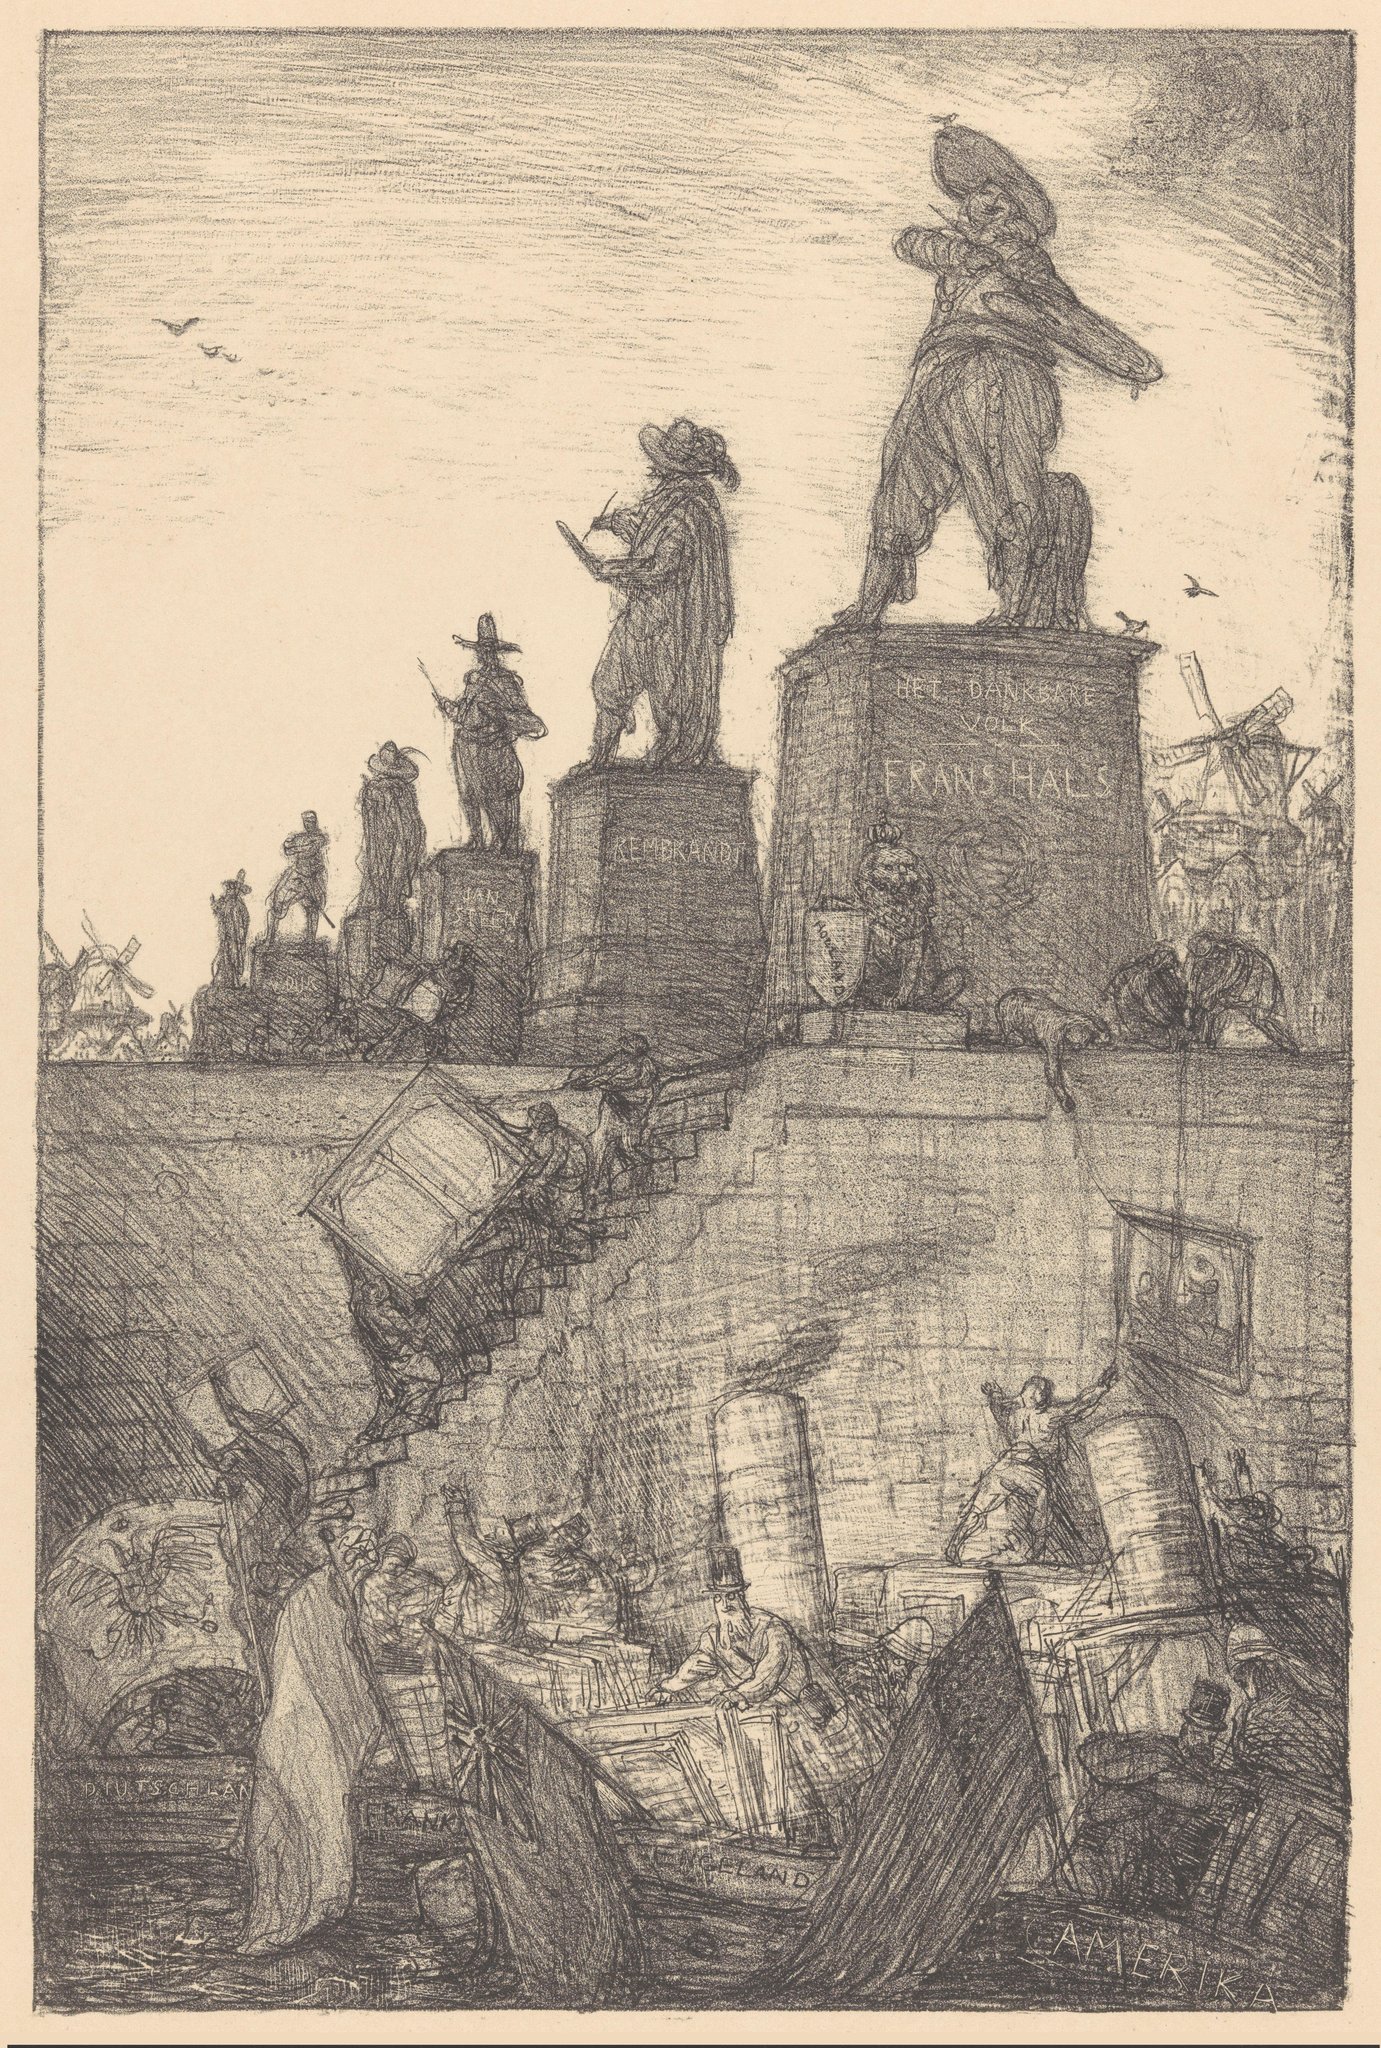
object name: print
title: Een standbeeld voor Frans Hals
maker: marius bauer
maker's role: draughtsman, print maker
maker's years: 1867-1932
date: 1895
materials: paper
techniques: lithograph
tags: antwerp, frans hals, jan havicksz. steen, leiden, painter, rembrandt van rijn, historical persons, monument, statue, picture, painting, political caricatures and satires, netherlands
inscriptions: collector's mark: Lugt 2228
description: Een standbeeld van Frans Hals is opgericht in een rij met beelden van Rembrandt, Jan Steen en andere kunstenaars. Op de voorgrond worden schilderijen in boten afgevoerd naar het buitenland. Spotprent op het oprichten van standbeelden voor kunstenaars, terwijl ondertussen hun werk naar het buitenland wordt verscheept. Verschenen in het bijvoegsel van 'De Kroniek' van 21 juli 1895.